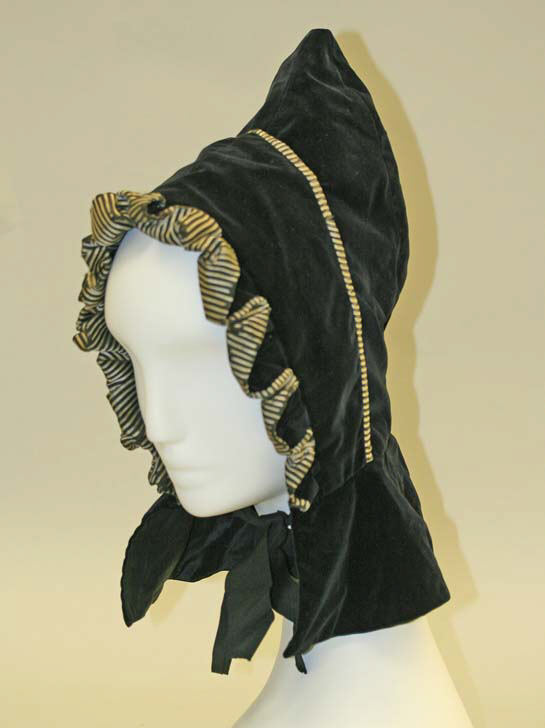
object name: hood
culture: american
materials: silk